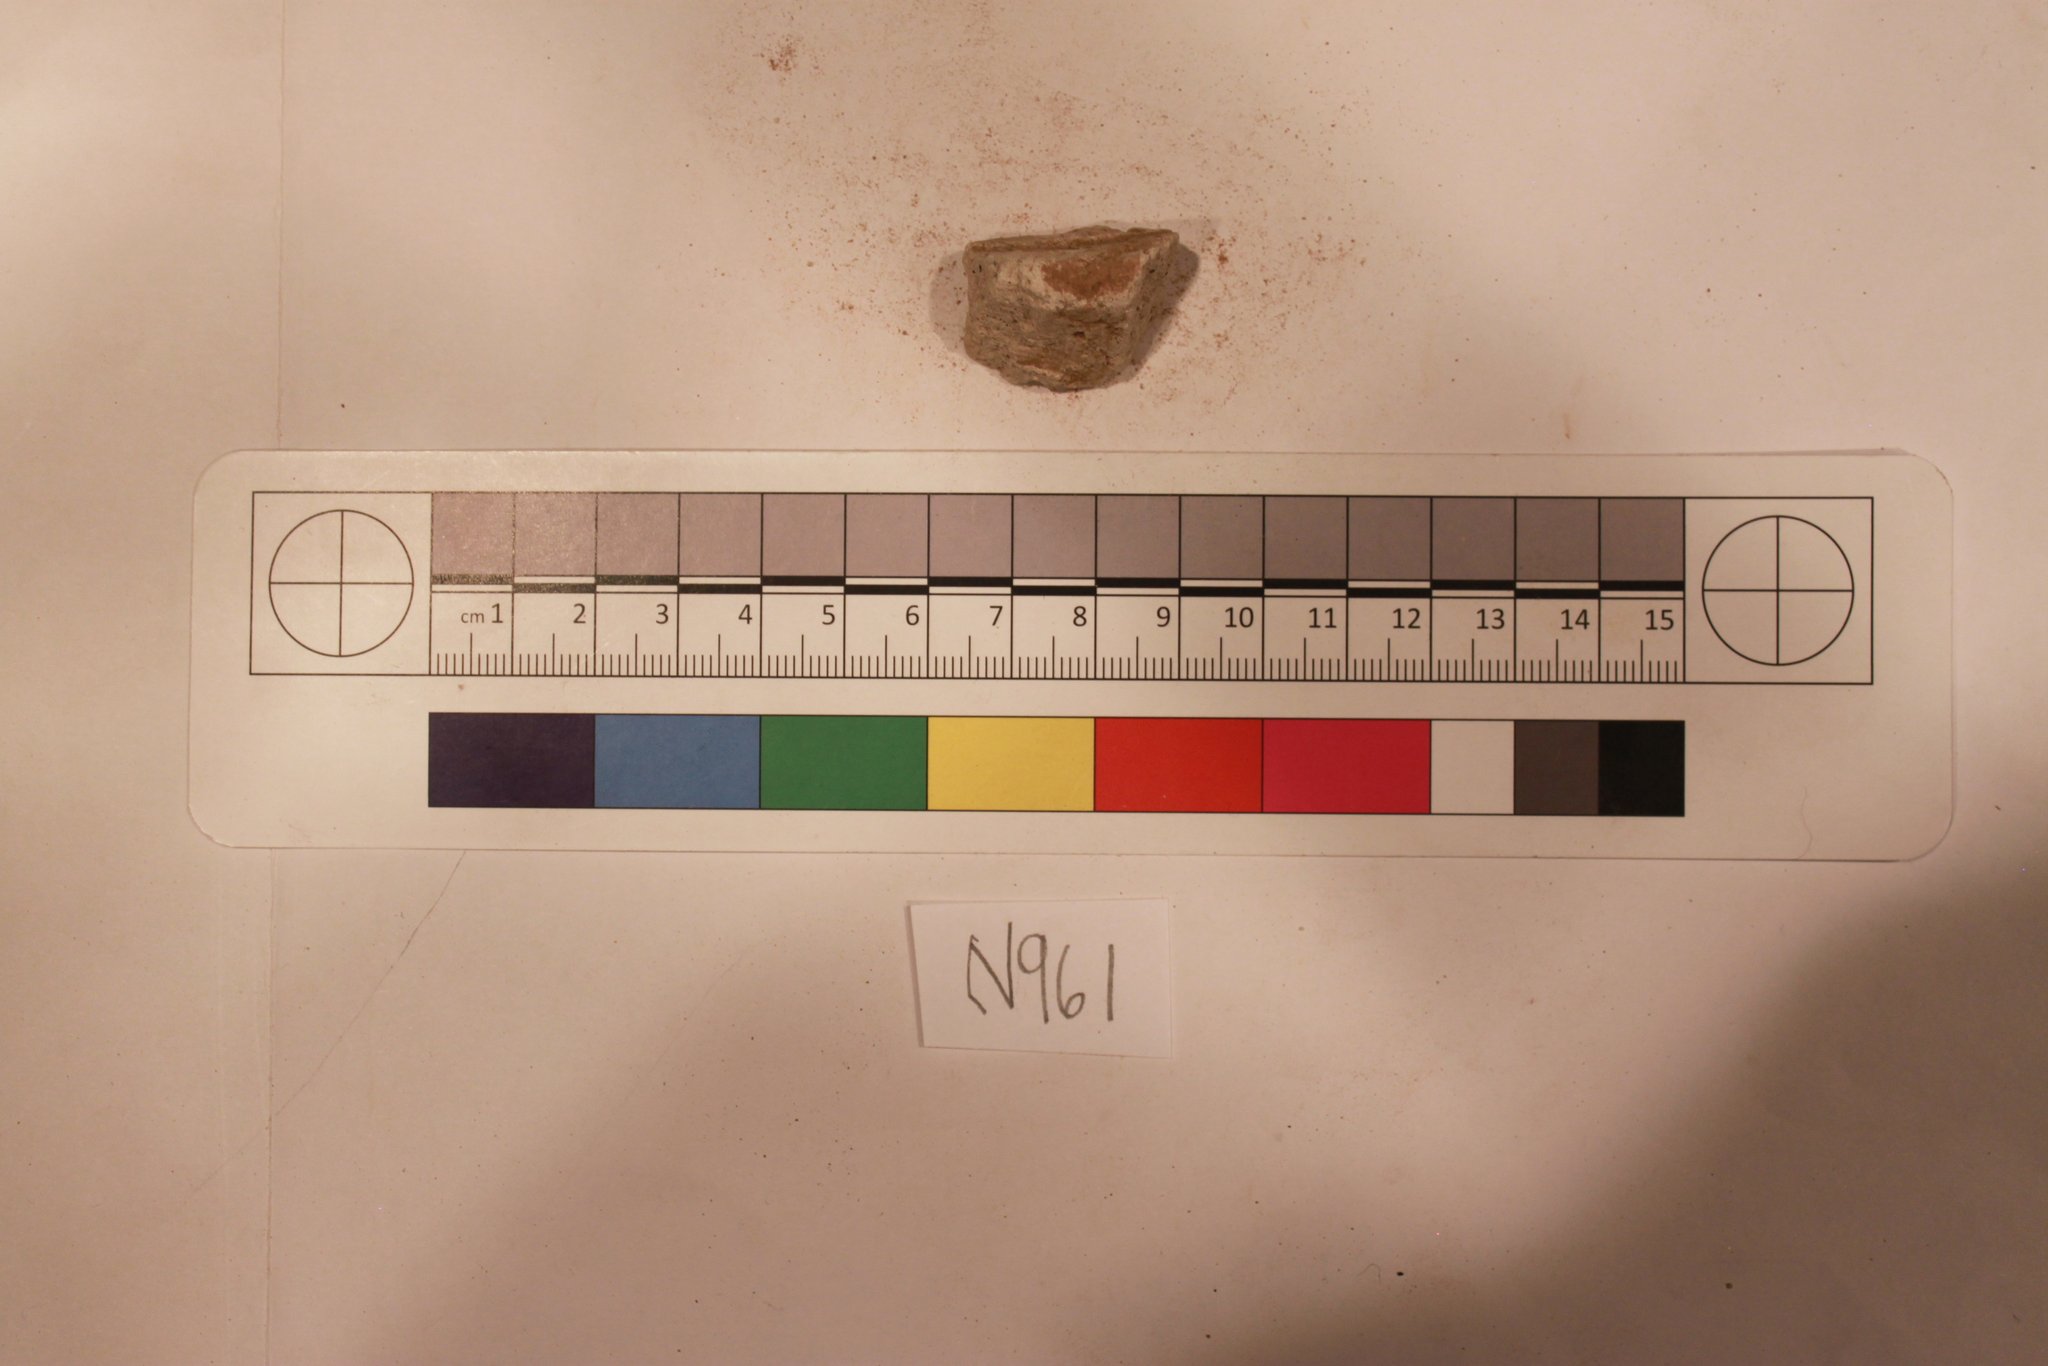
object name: fragment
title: Stucco Fragment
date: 701-1200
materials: plaster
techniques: carving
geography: iran